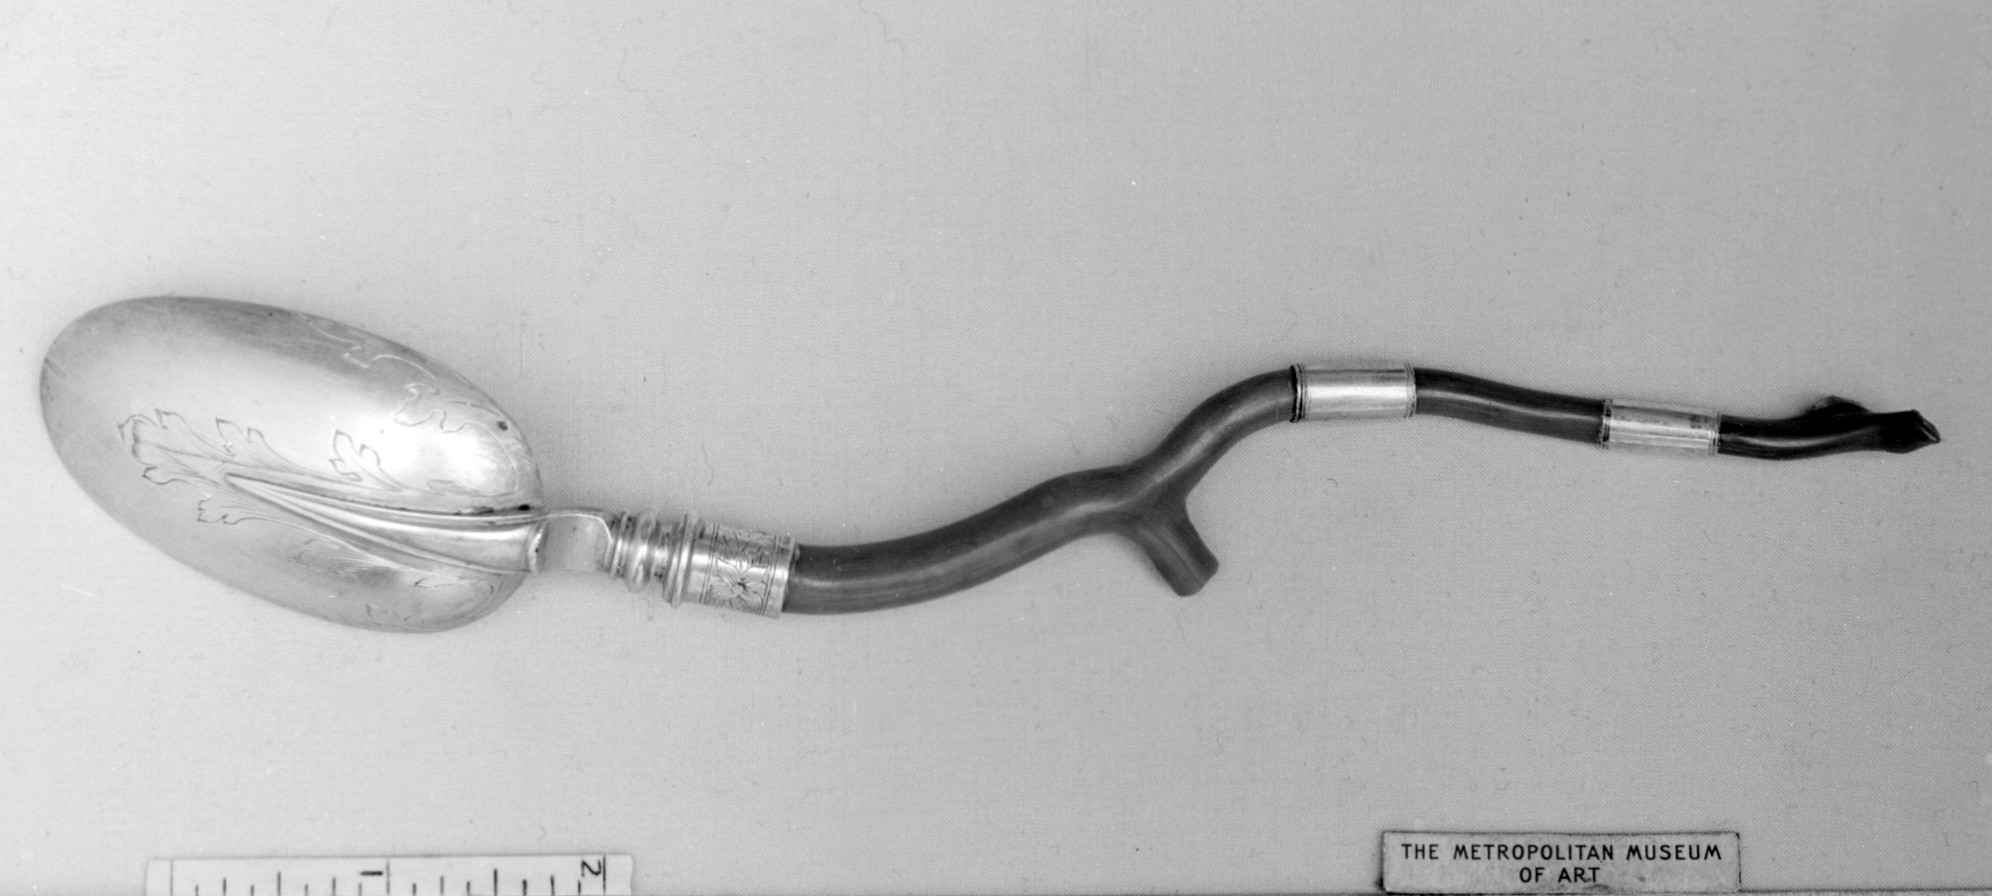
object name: spoon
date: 1667-1733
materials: coral, silver